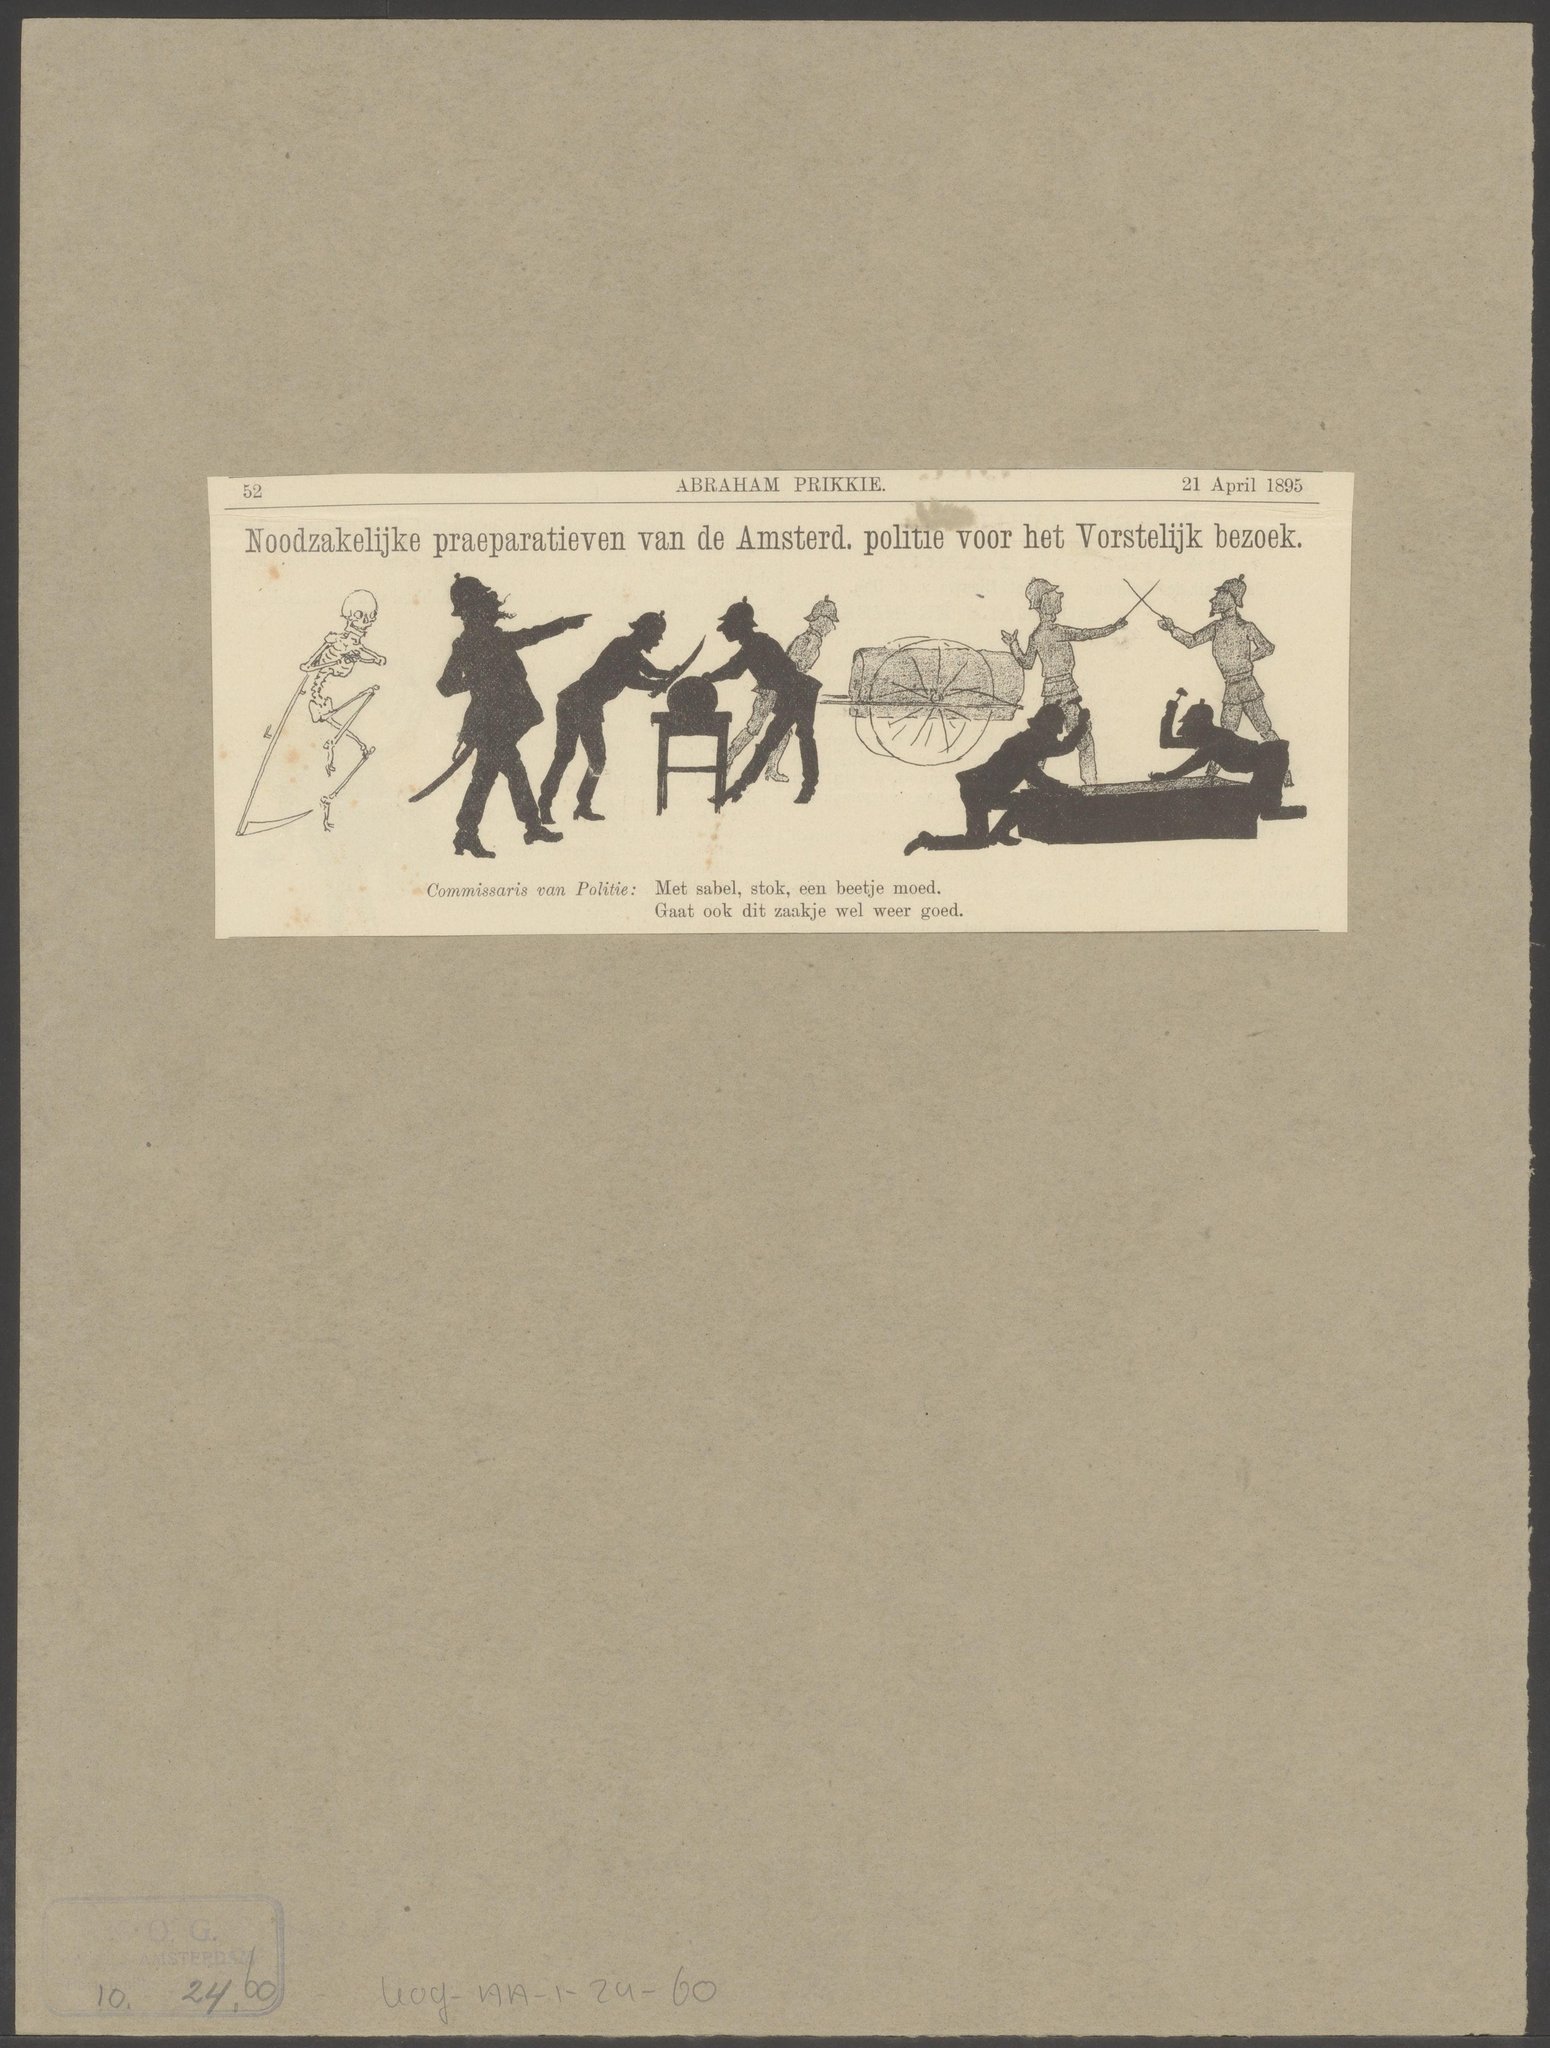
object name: photomechanical print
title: Politieagenten voeren handelingen uit terwijl de Dood toekijkt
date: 1895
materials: paper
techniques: letterpress printing, line block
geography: netherlands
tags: death as skeleton (+ death with scythe), coffin, police, amsterdam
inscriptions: collector's mark: Lugt 1641b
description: Prent uit: Abraham Prikkie's op- en aanmerkingen, 21 april 1895.